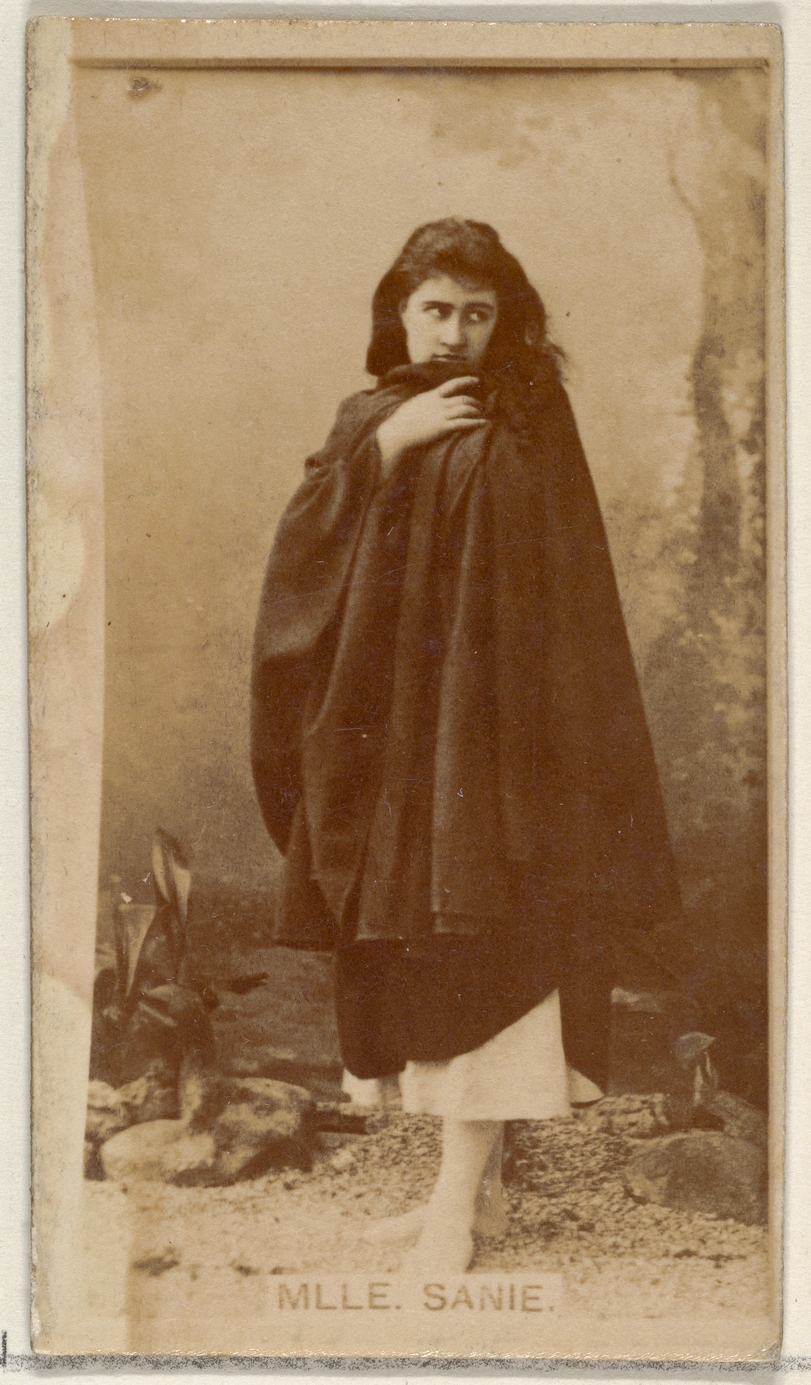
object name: photograph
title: Mlle. Sanie, from the Actors and Actresses series (N45, Type 8) for Virginia Brights Cigarettes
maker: allen & ginter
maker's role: publisher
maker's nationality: american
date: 1888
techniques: albumen silver print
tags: portraits,women,actresses